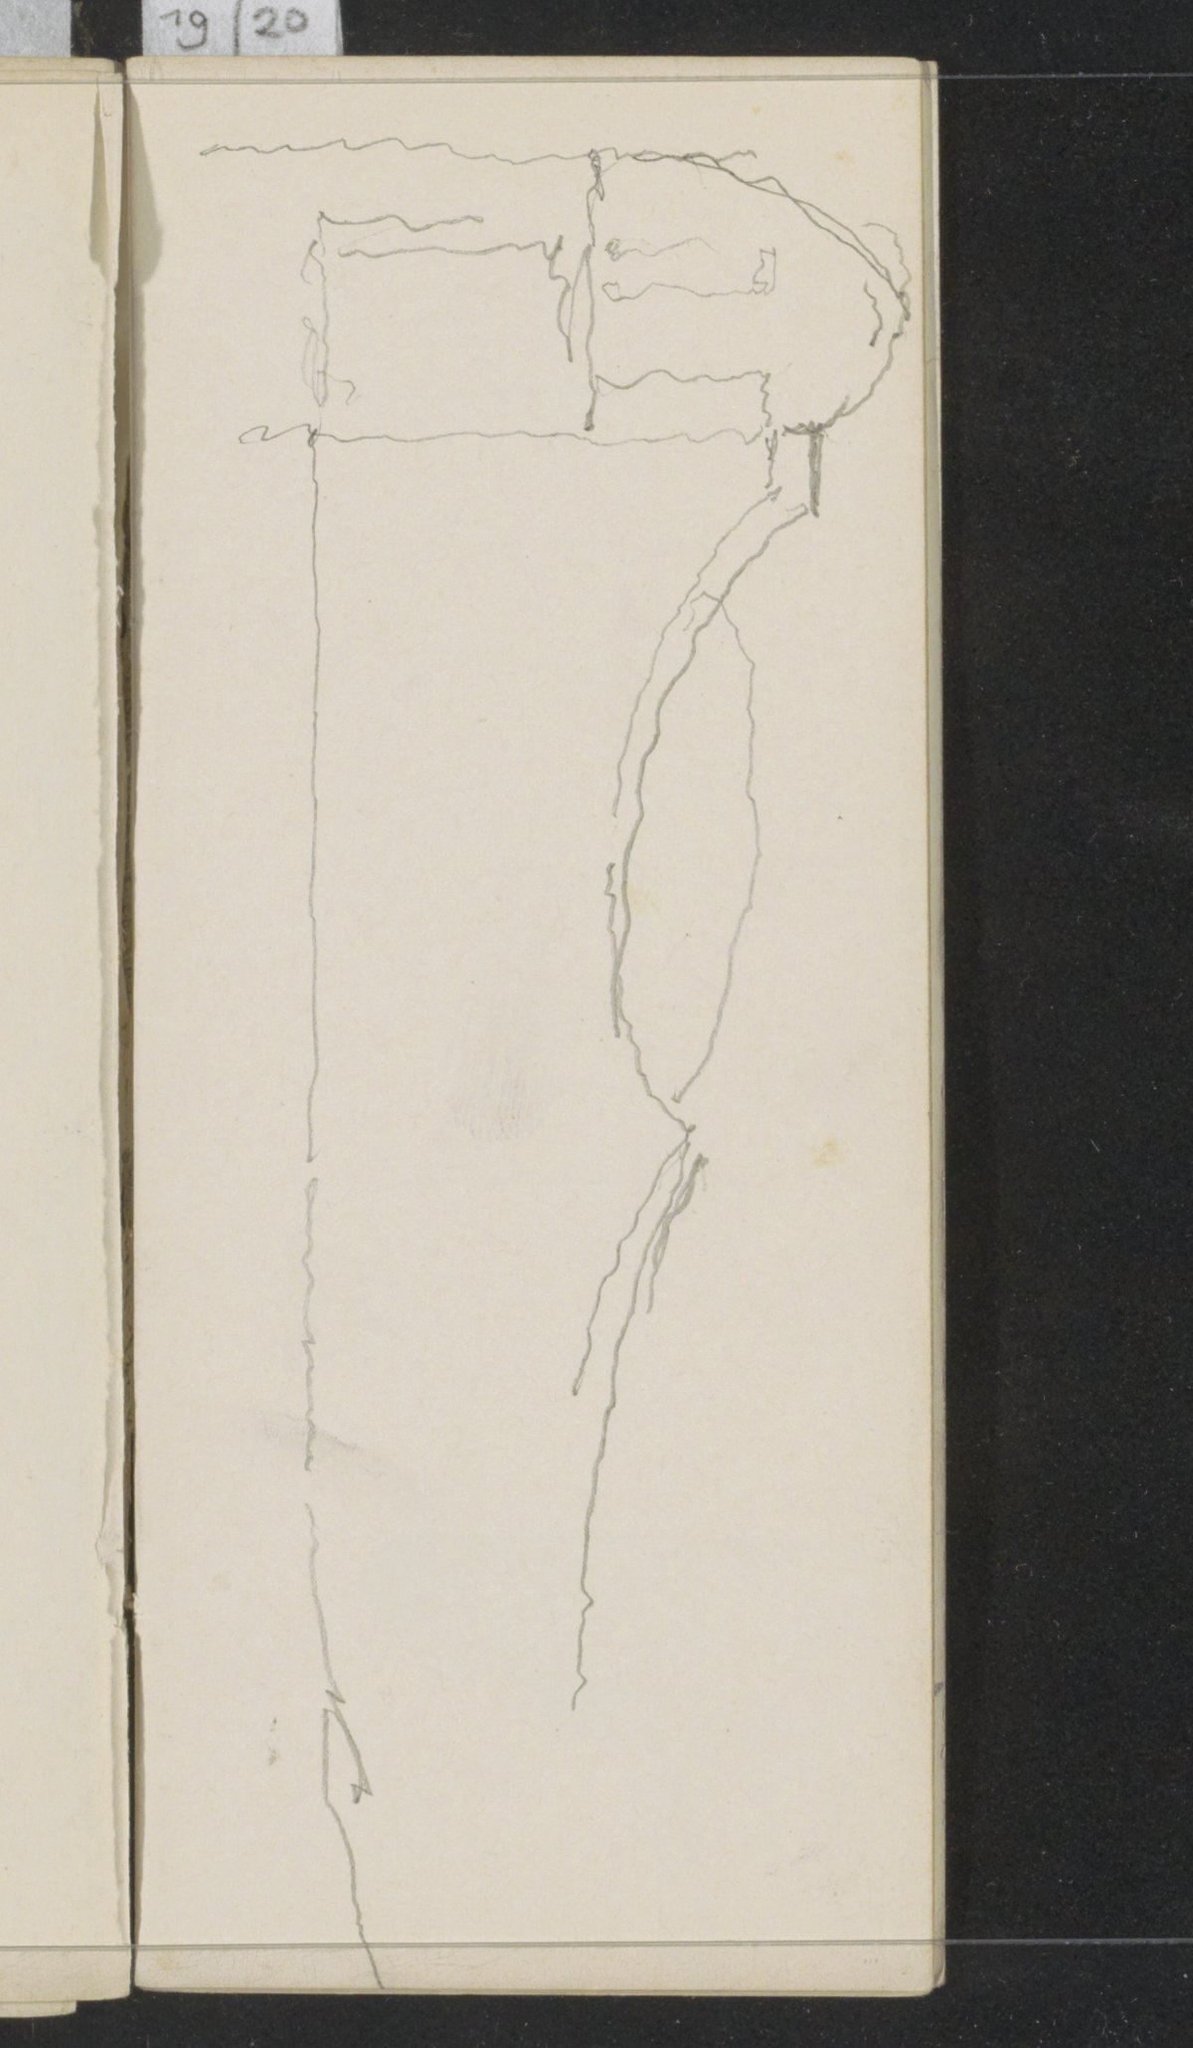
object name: sketchbook leaf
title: Studie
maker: gerrit willem dijsselhof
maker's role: designer, draughtsman, print maker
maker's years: 1866-1924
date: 1876-1924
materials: paper, pencil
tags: architecture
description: Mogelijk een architectuurstudie. Blad 17 recto uit een schetsboek met 24 bladen.